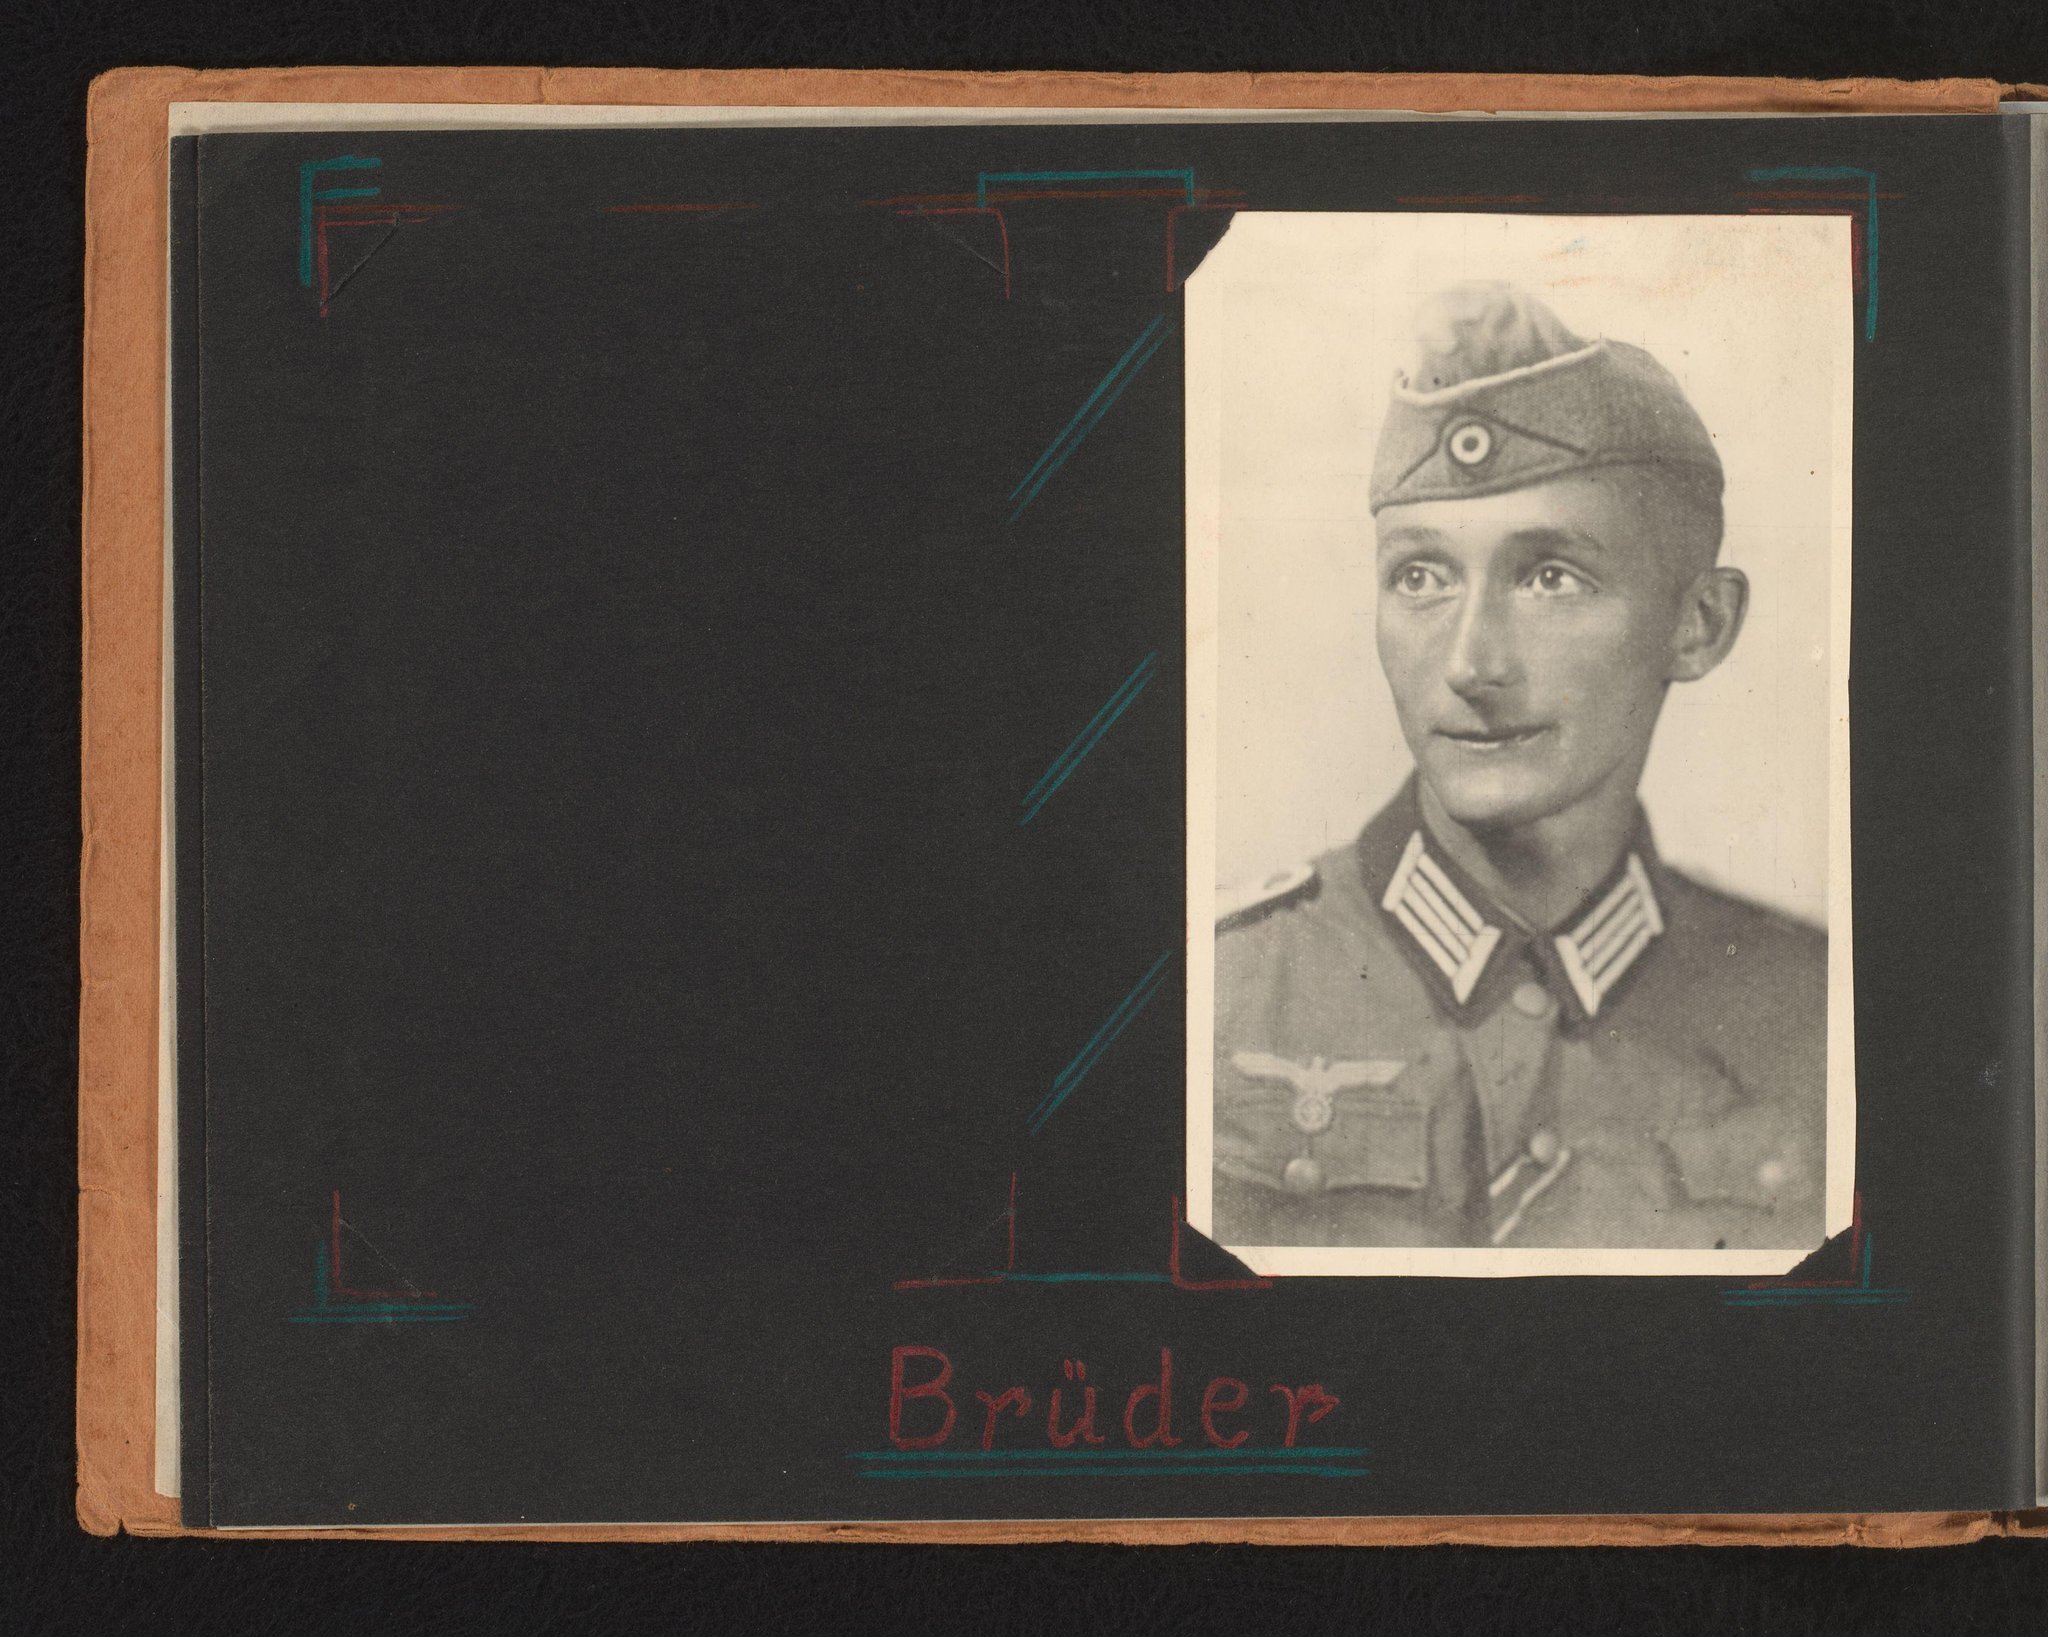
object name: photograph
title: Brüder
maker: Anonymous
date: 1940-1943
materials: paper, photographic support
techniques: gelatin silver print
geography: germany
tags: historical persons not known by name, germany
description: Albumblad met een portret van een Duitse militair, een broer van Werner Neufang. Onderdeel van een fotoalbum over de Duitse Werner Neufang van de Kriegsmarine en de Nederlandse Thea Driesen.